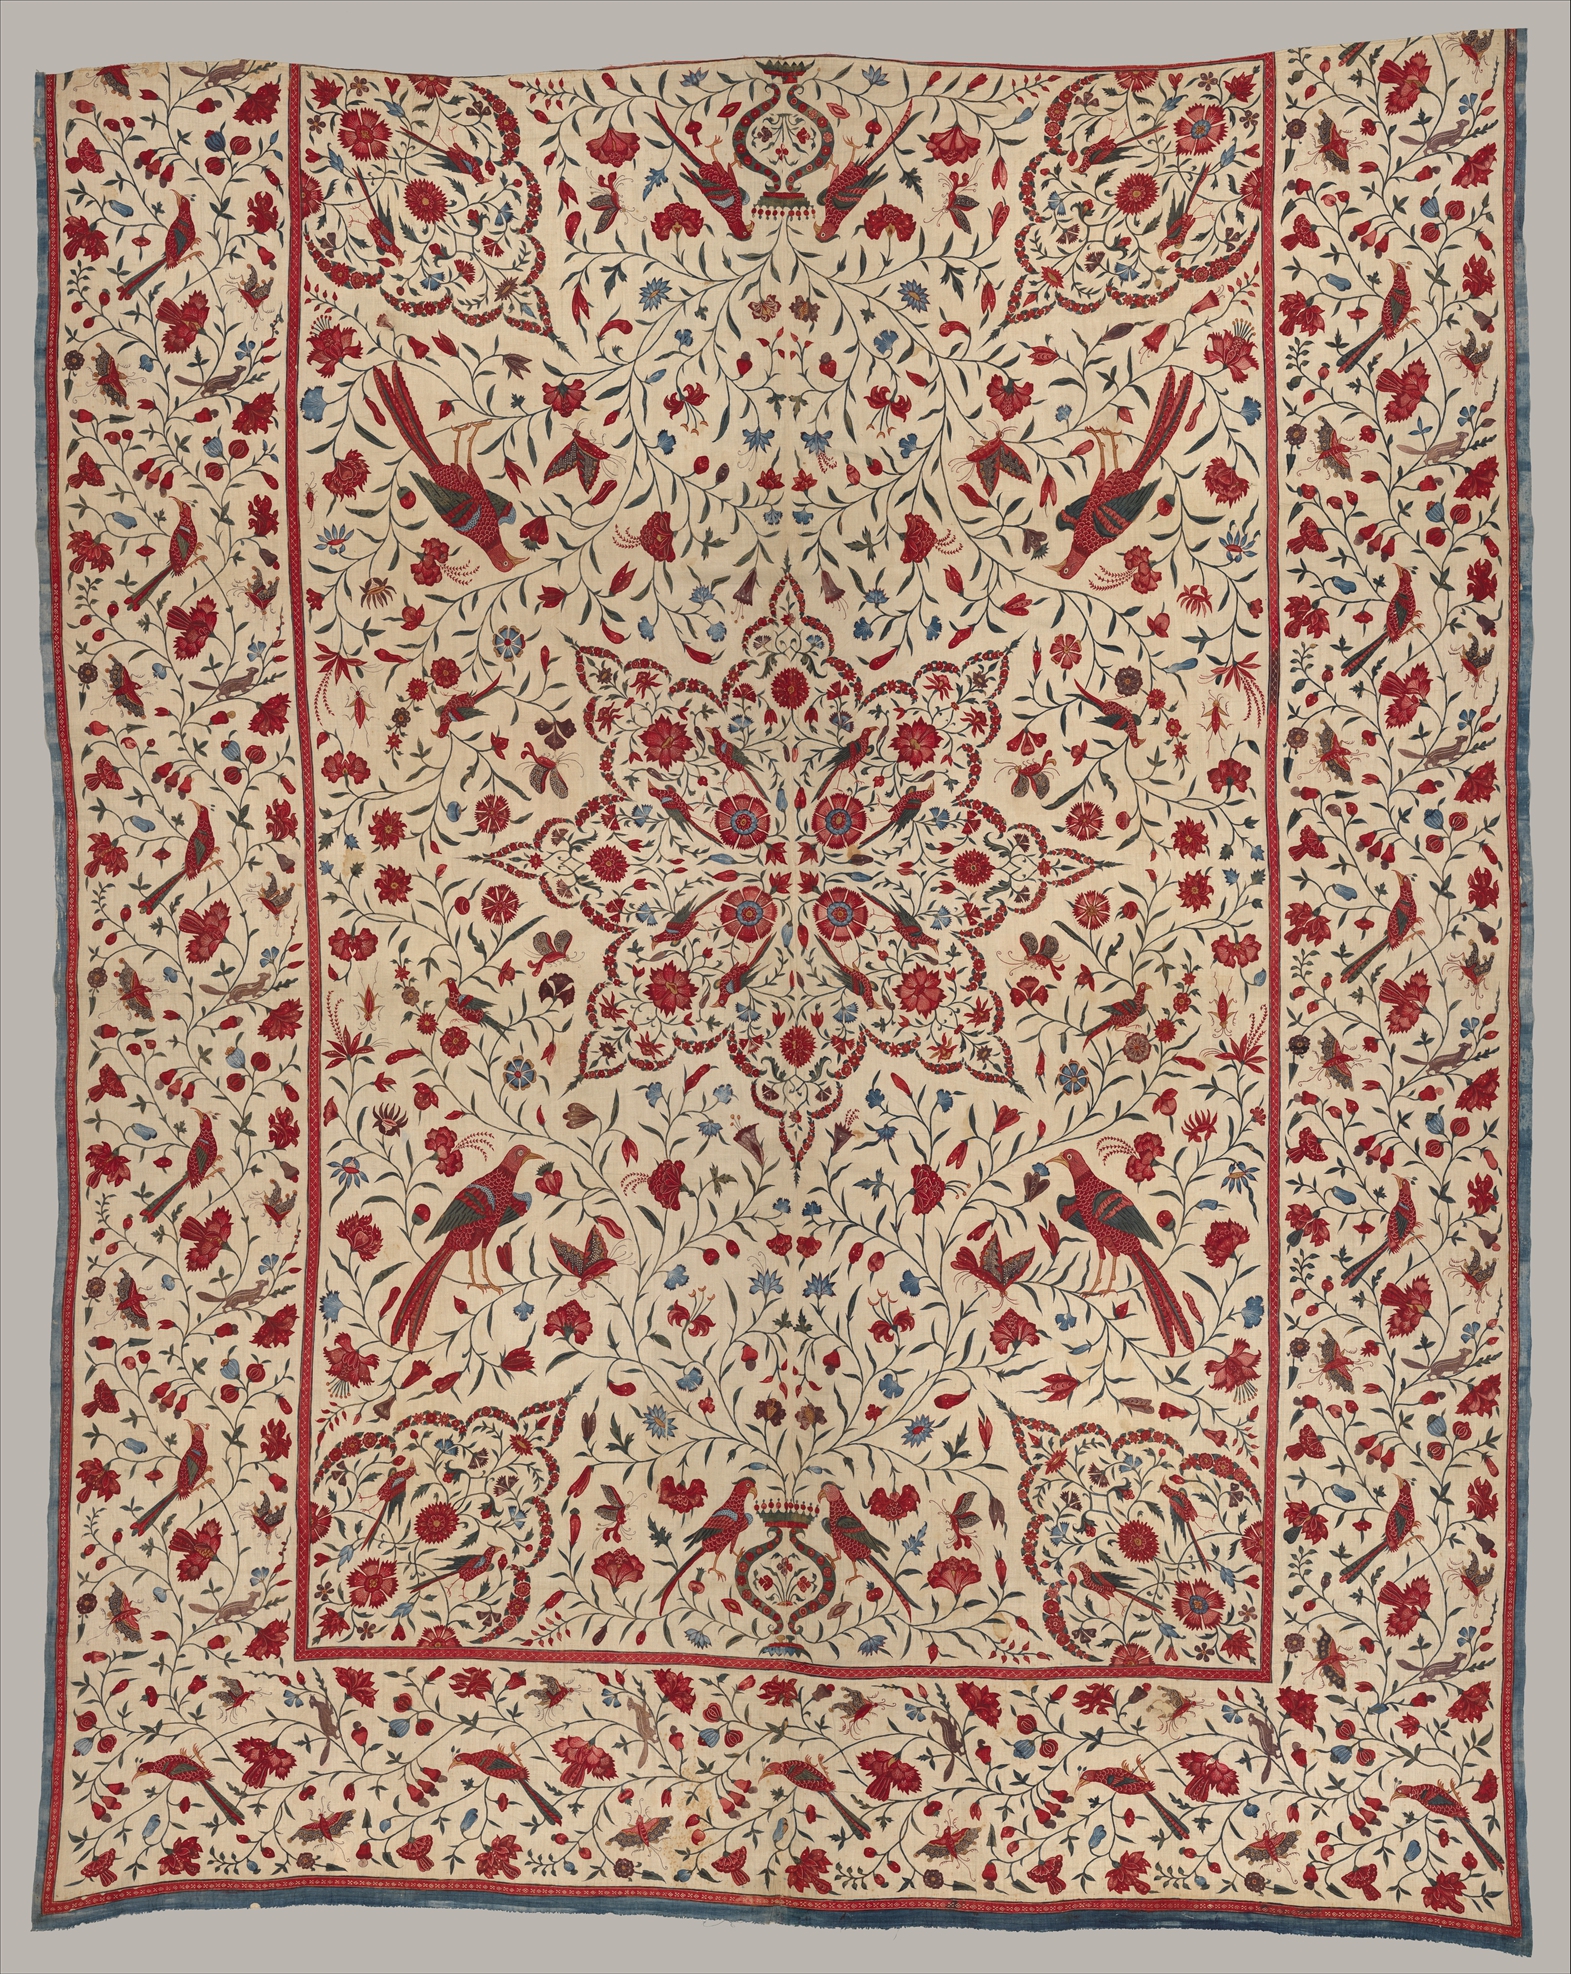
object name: hanging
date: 1701-1800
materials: cotton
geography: india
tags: birds,flowers